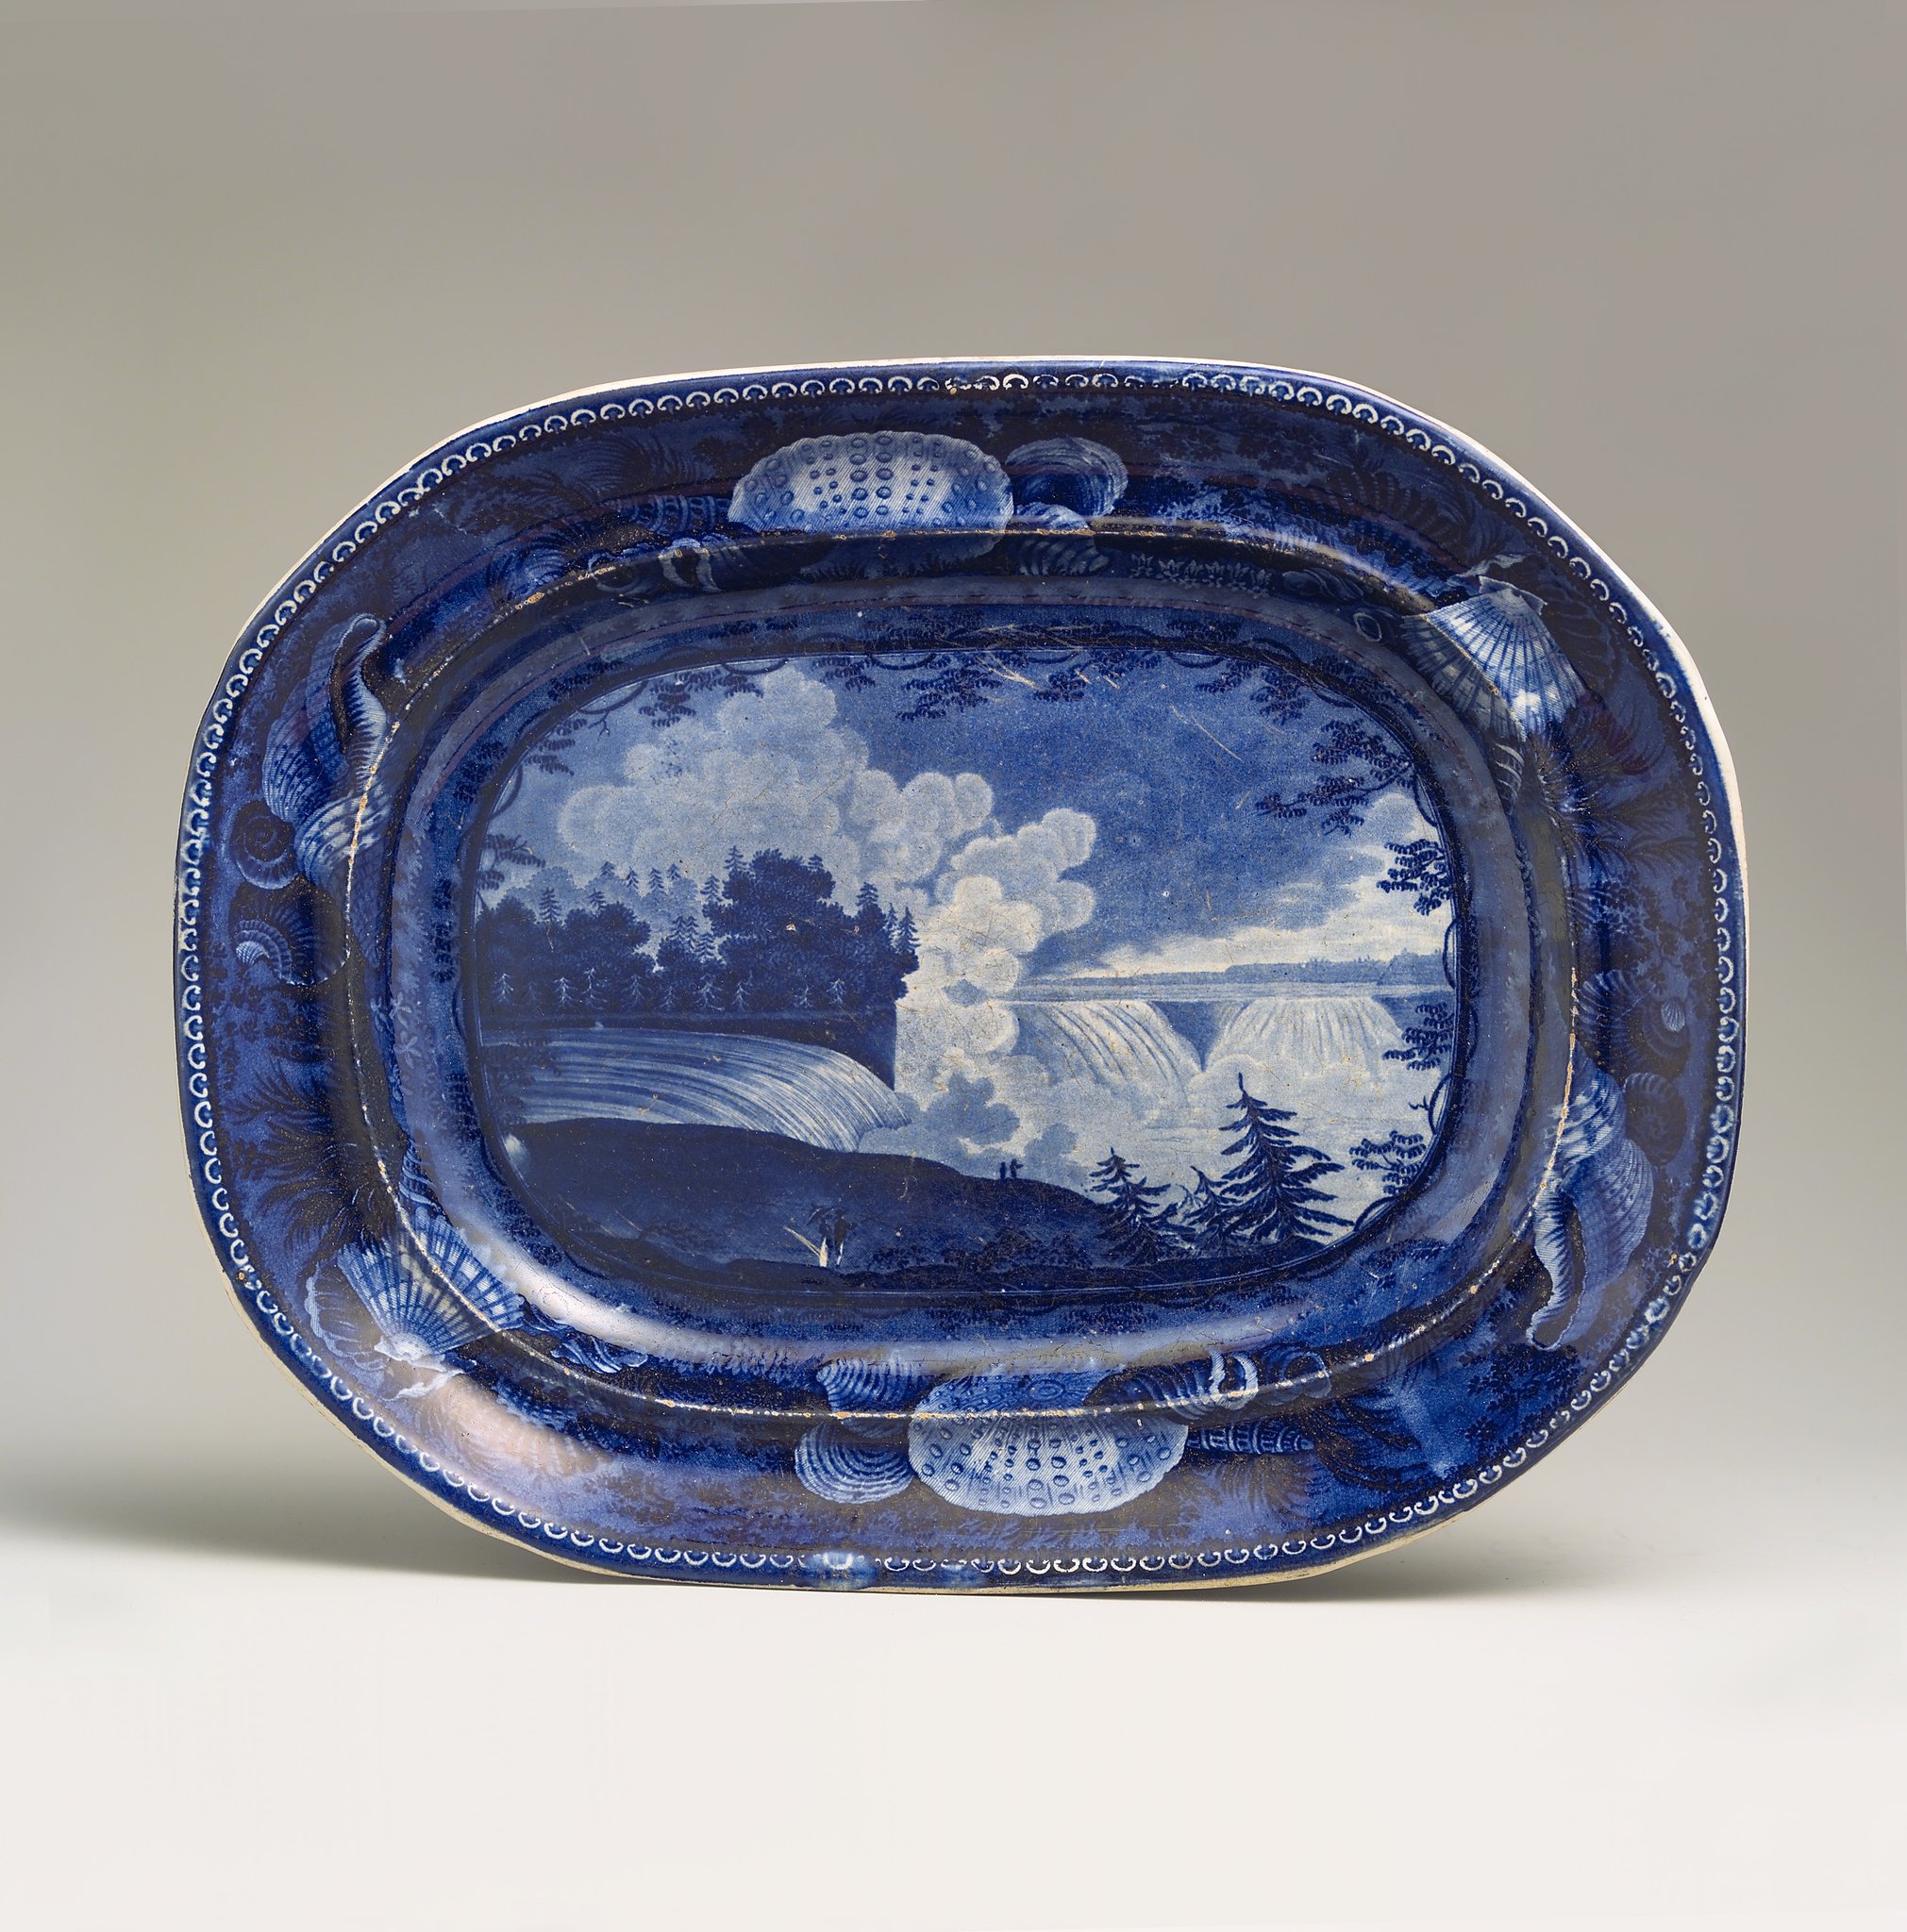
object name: platter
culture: british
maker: enoch wood & sons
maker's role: maker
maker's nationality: british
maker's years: 1818-1846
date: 1828-1846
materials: earthenware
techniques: transfer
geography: england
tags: waterfalls,shells